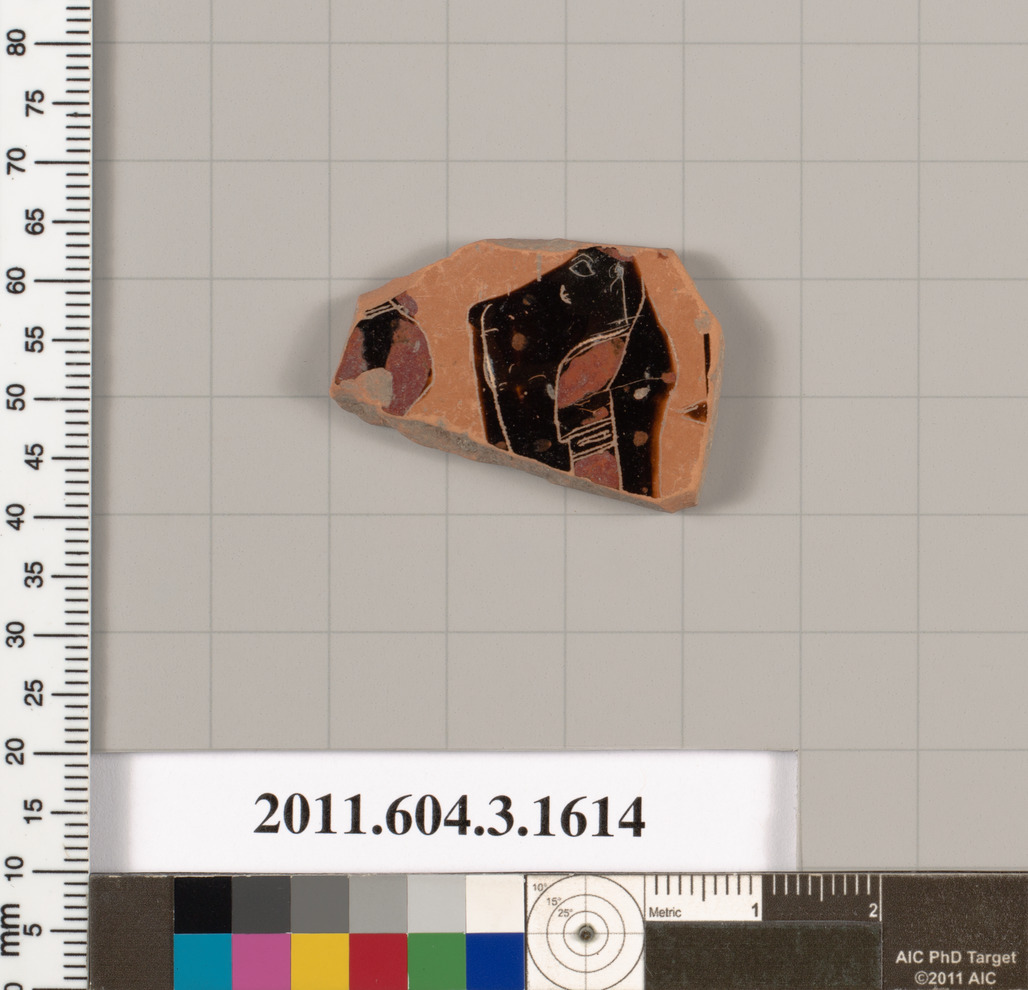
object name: kylix fragment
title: Terracotta fragment of a kylix: Band cup (drinking cup)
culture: greek, attic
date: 550-526 BCE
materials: terracotta